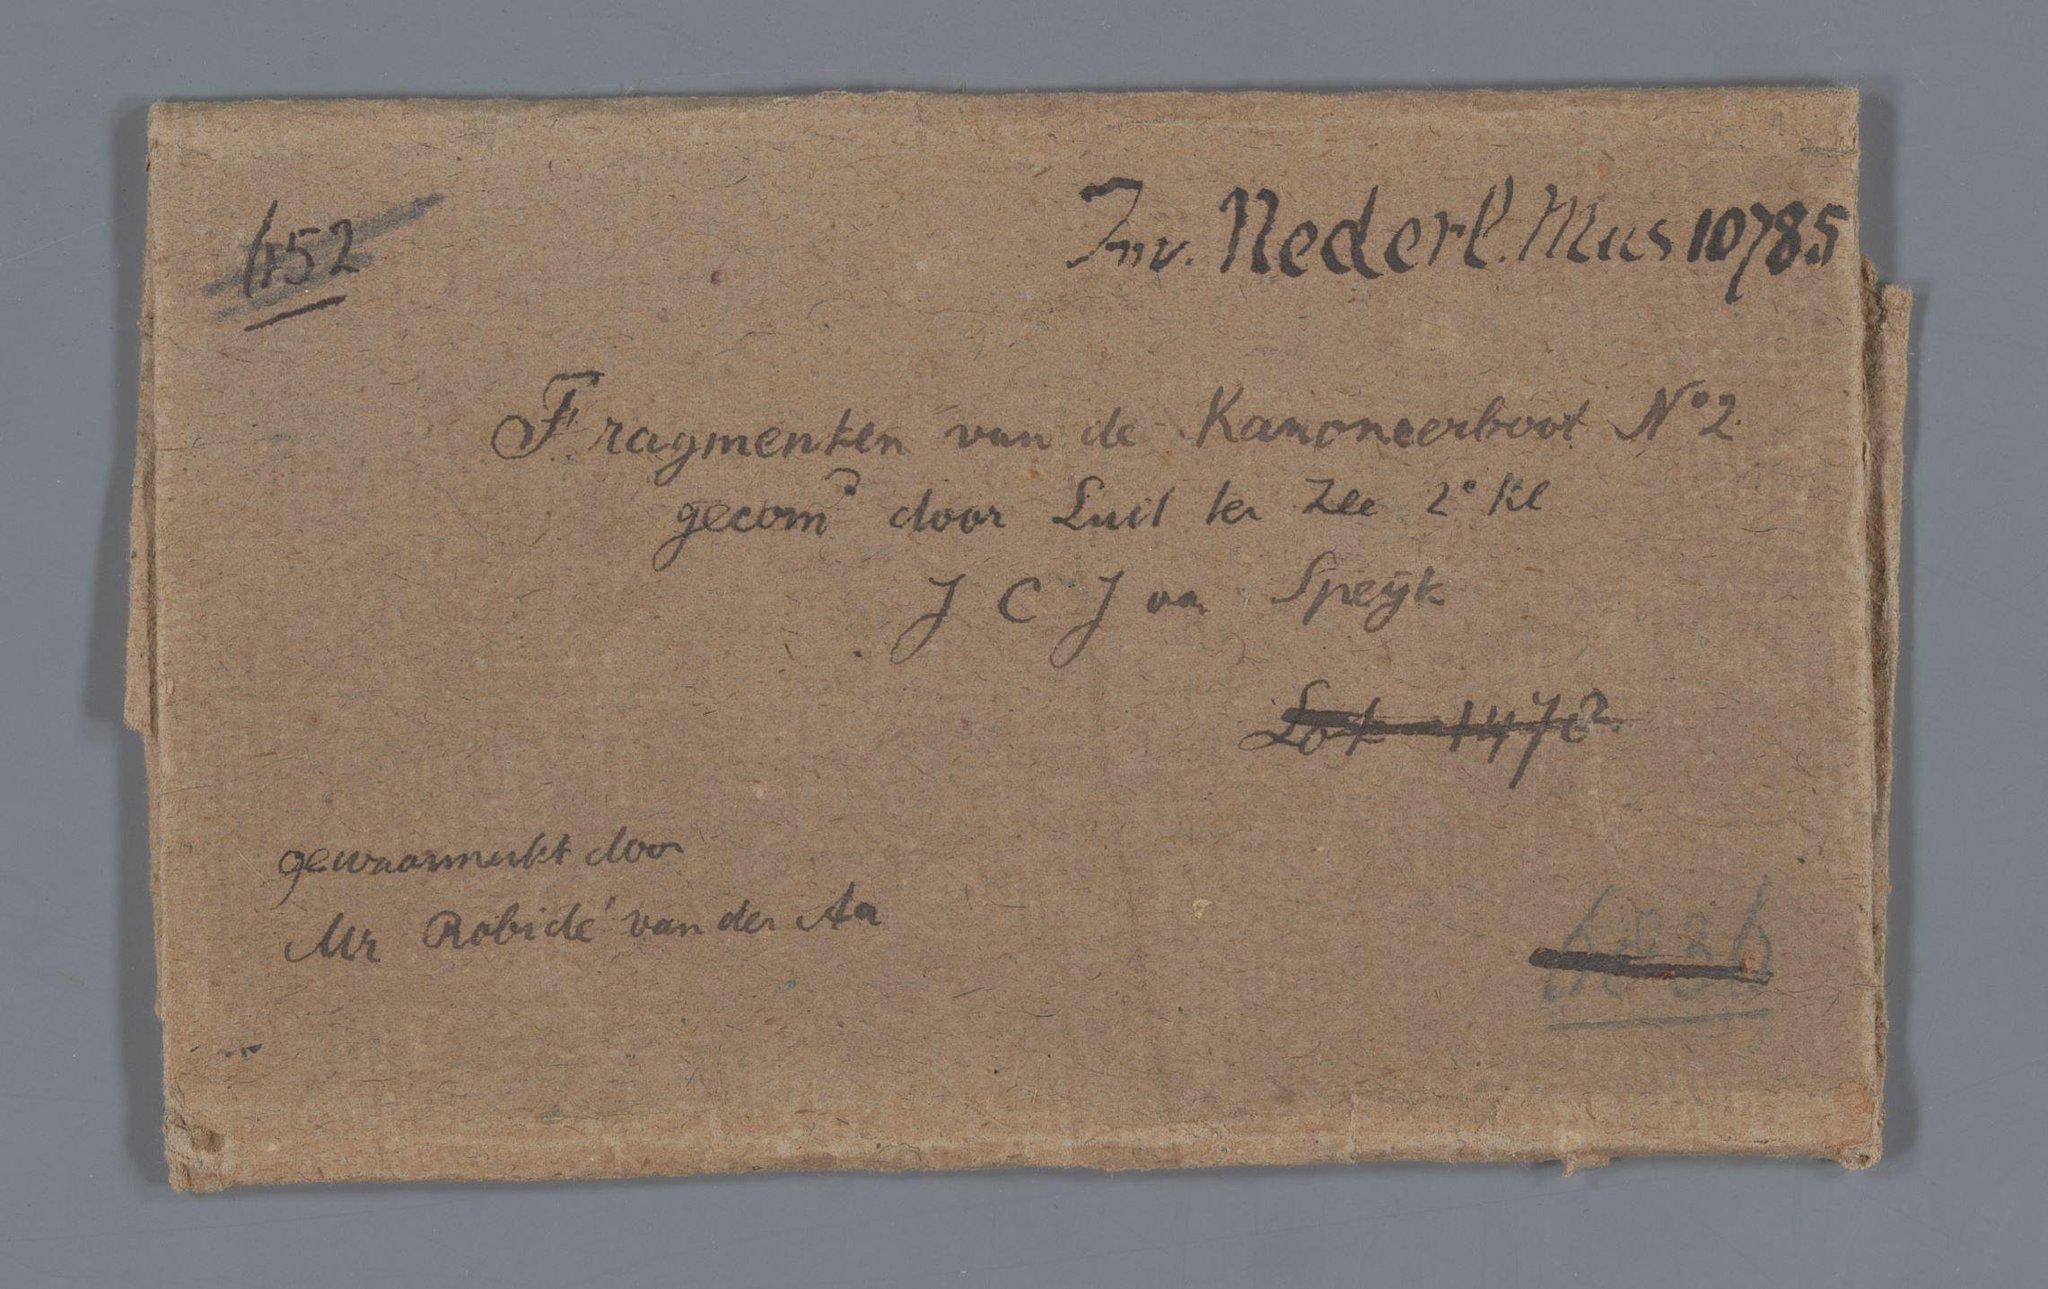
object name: paper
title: Document over de fragmenten van de kanonneerboot No. 2 van J.C.J. van Speyk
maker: christianus petrus eliza robidé van der aa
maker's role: advocaat, rechtsgeleerde, schrijver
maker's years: 1791-1851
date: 1800-1830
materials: paper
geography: netherlands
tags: amsterdam, antwerp, jan van speyk, belgium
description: Remains from Van Speyk's gunboat, objects made from remains, pieces of Van Speyk's uniform. After the gunboat had exploded what was left of the vessel was fished out of the Scheldt. The remains were treasured like relics. Objects such as boxes, pens, rings and the like were made and given away as prizes in a lottery in aid of a national monument for Van Speyk. There were nearly a thousand prizes to be won. The proceeds were used to build the Van Speyk lighthouse at Egmond aan Zee. The lottery was organized by Mr C.P.E. Robidé van der Aa (1791-1851), the same man who founded the magazine De Gids with E.J. Potgieter in 1837. Some of the items displayed here appeared in the lottery.